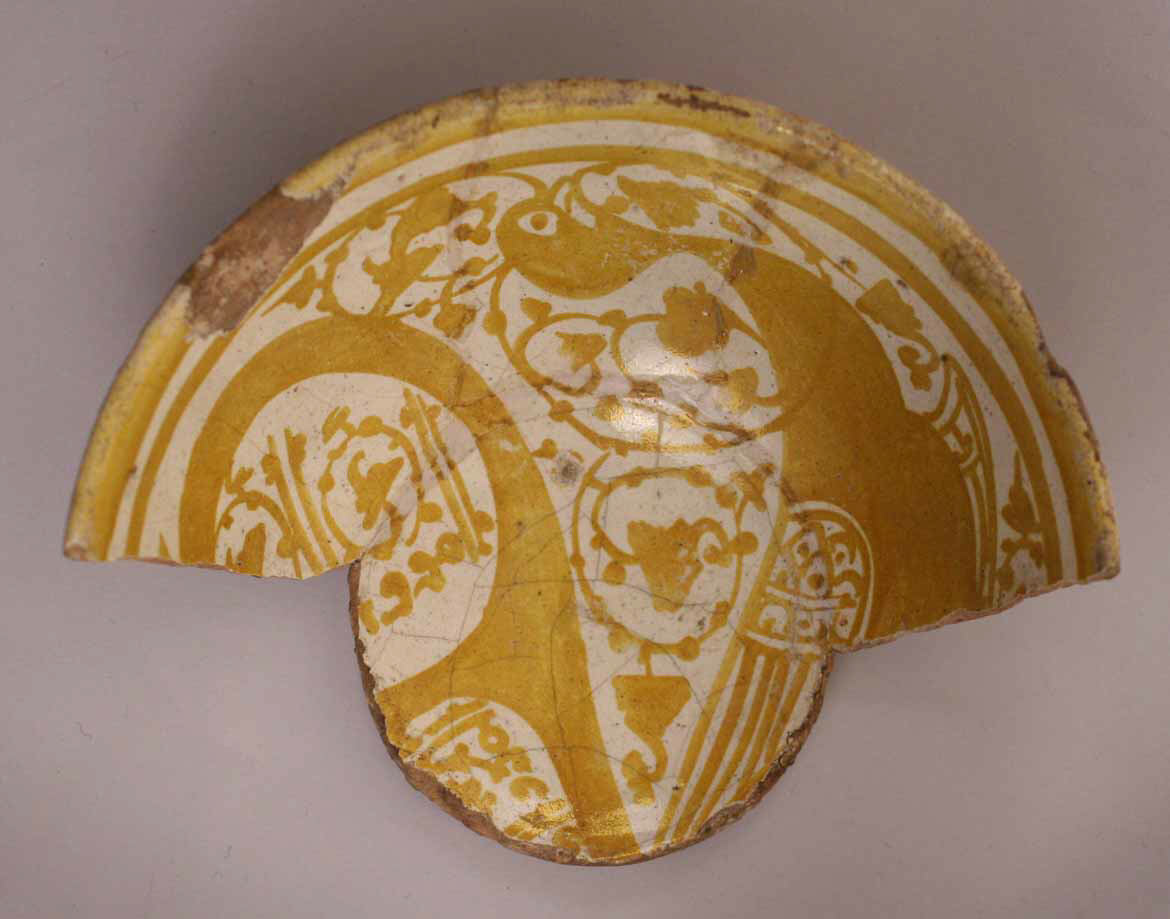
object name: fragment of a bowl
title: Fragment of a Luster Bowl with a Peacock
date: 1001-1100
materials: glaze, stonepaste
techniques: painting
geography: egypt